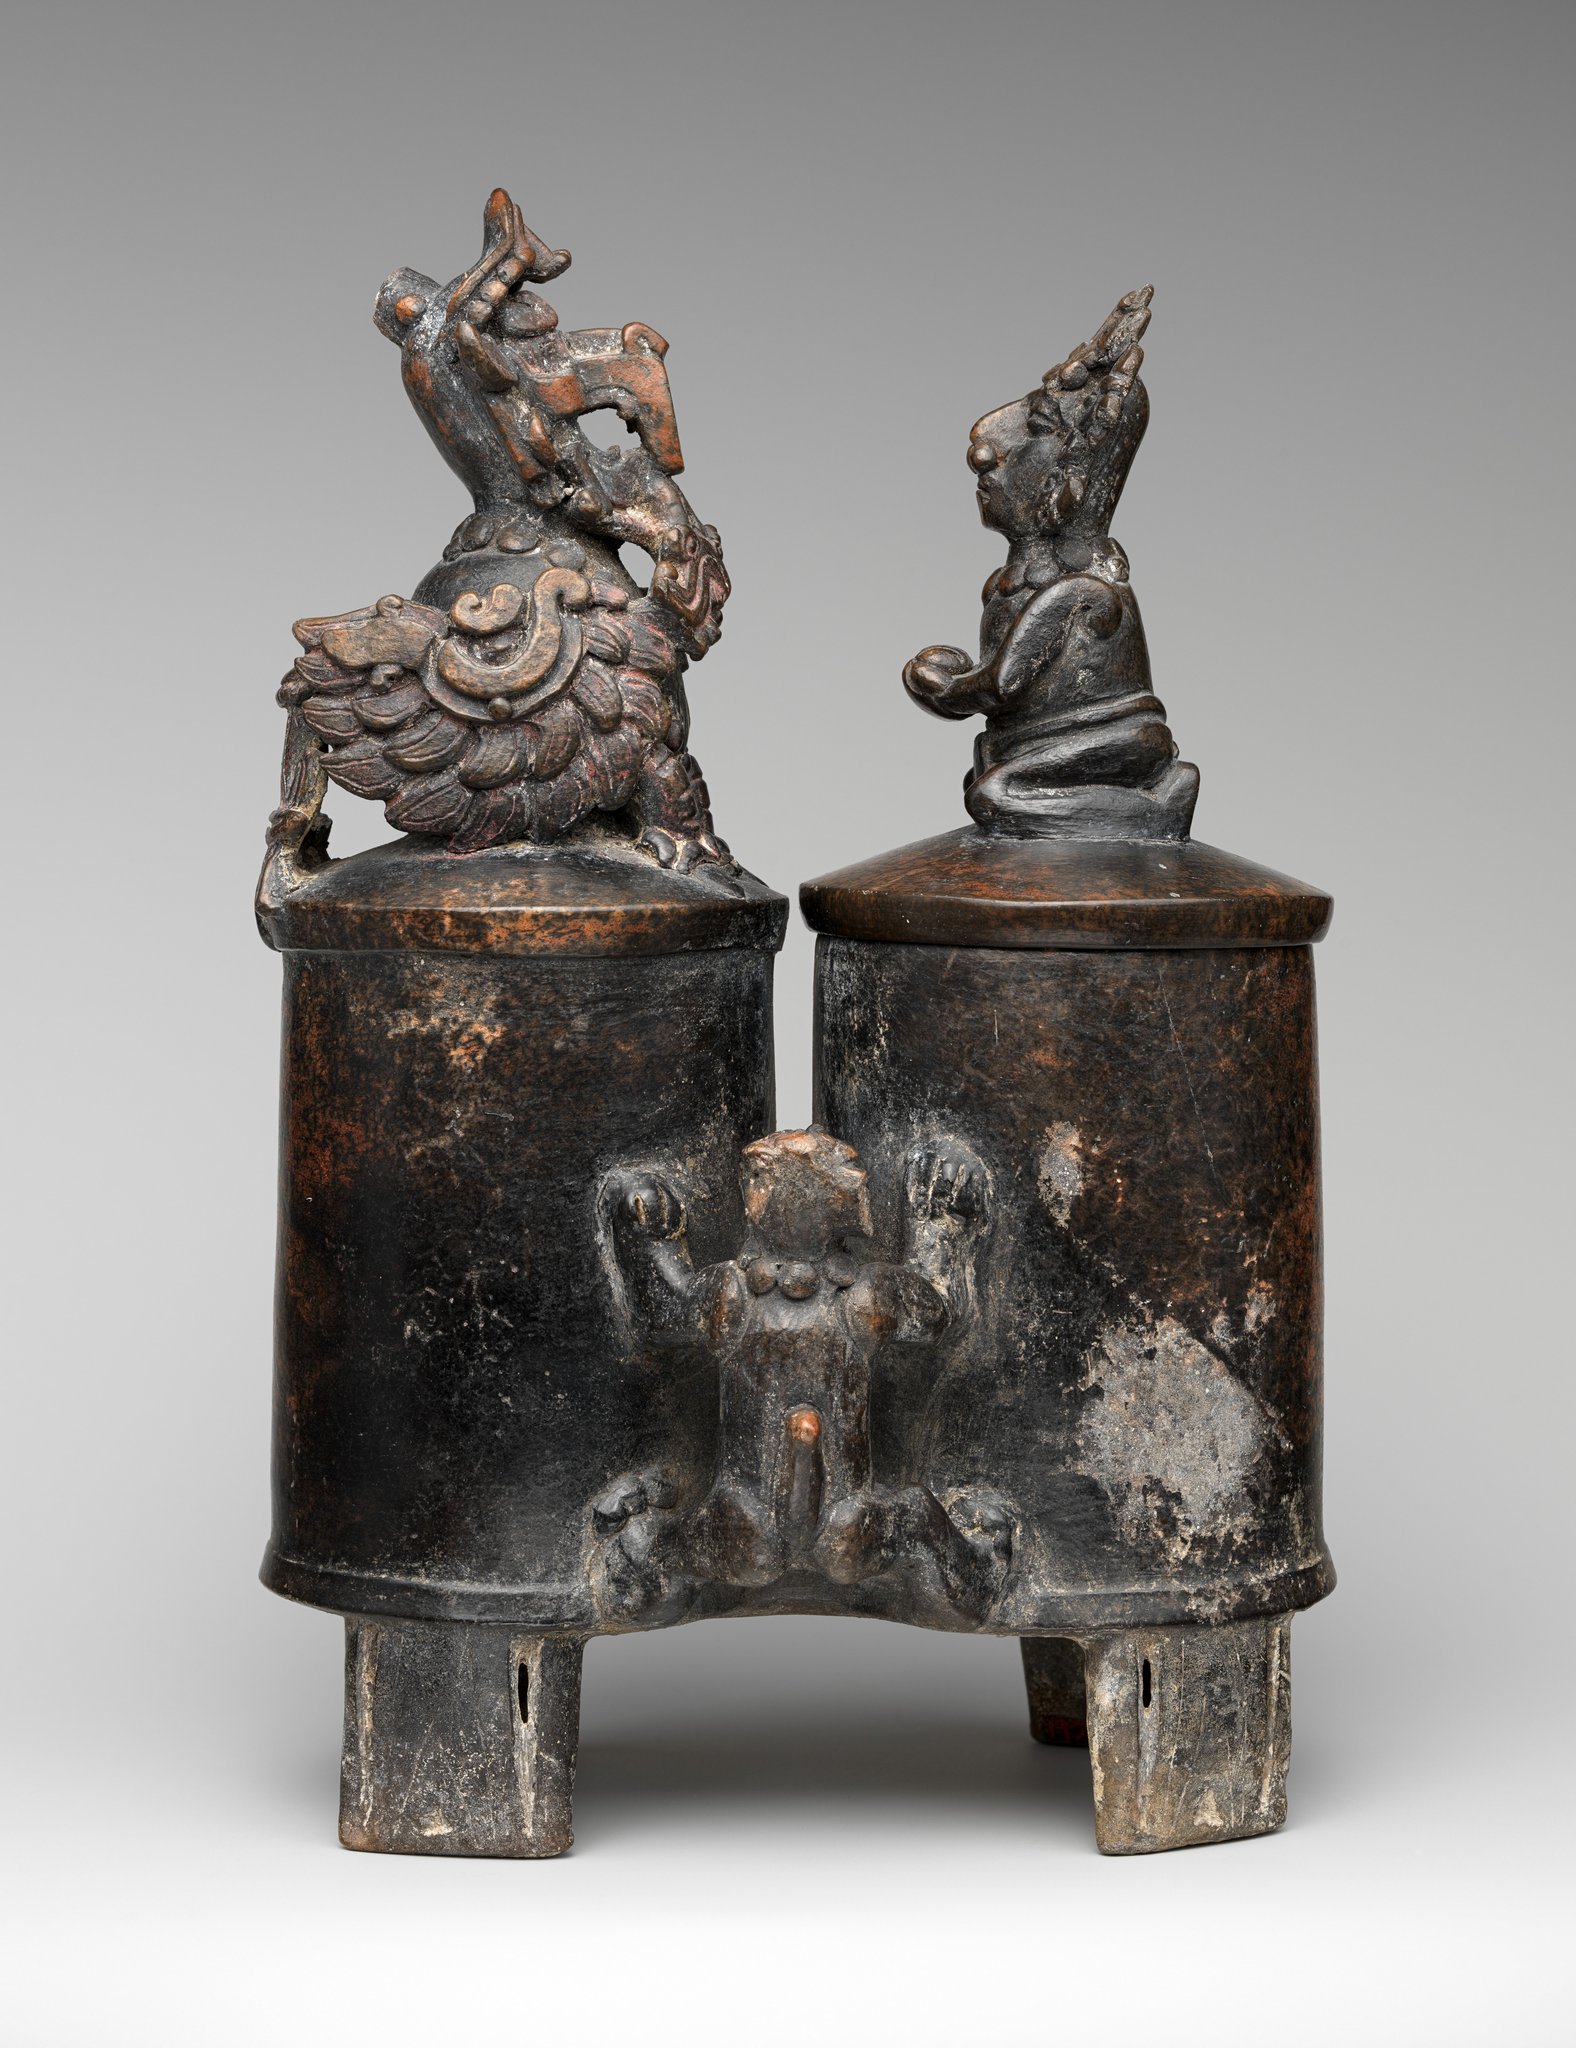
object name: vessel with lid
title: Whistling vessel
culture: maya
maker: maya artist(s)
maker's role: artist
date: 400-500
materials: ceramic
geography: guatemala or mexico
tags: birds,men,mythical creatures